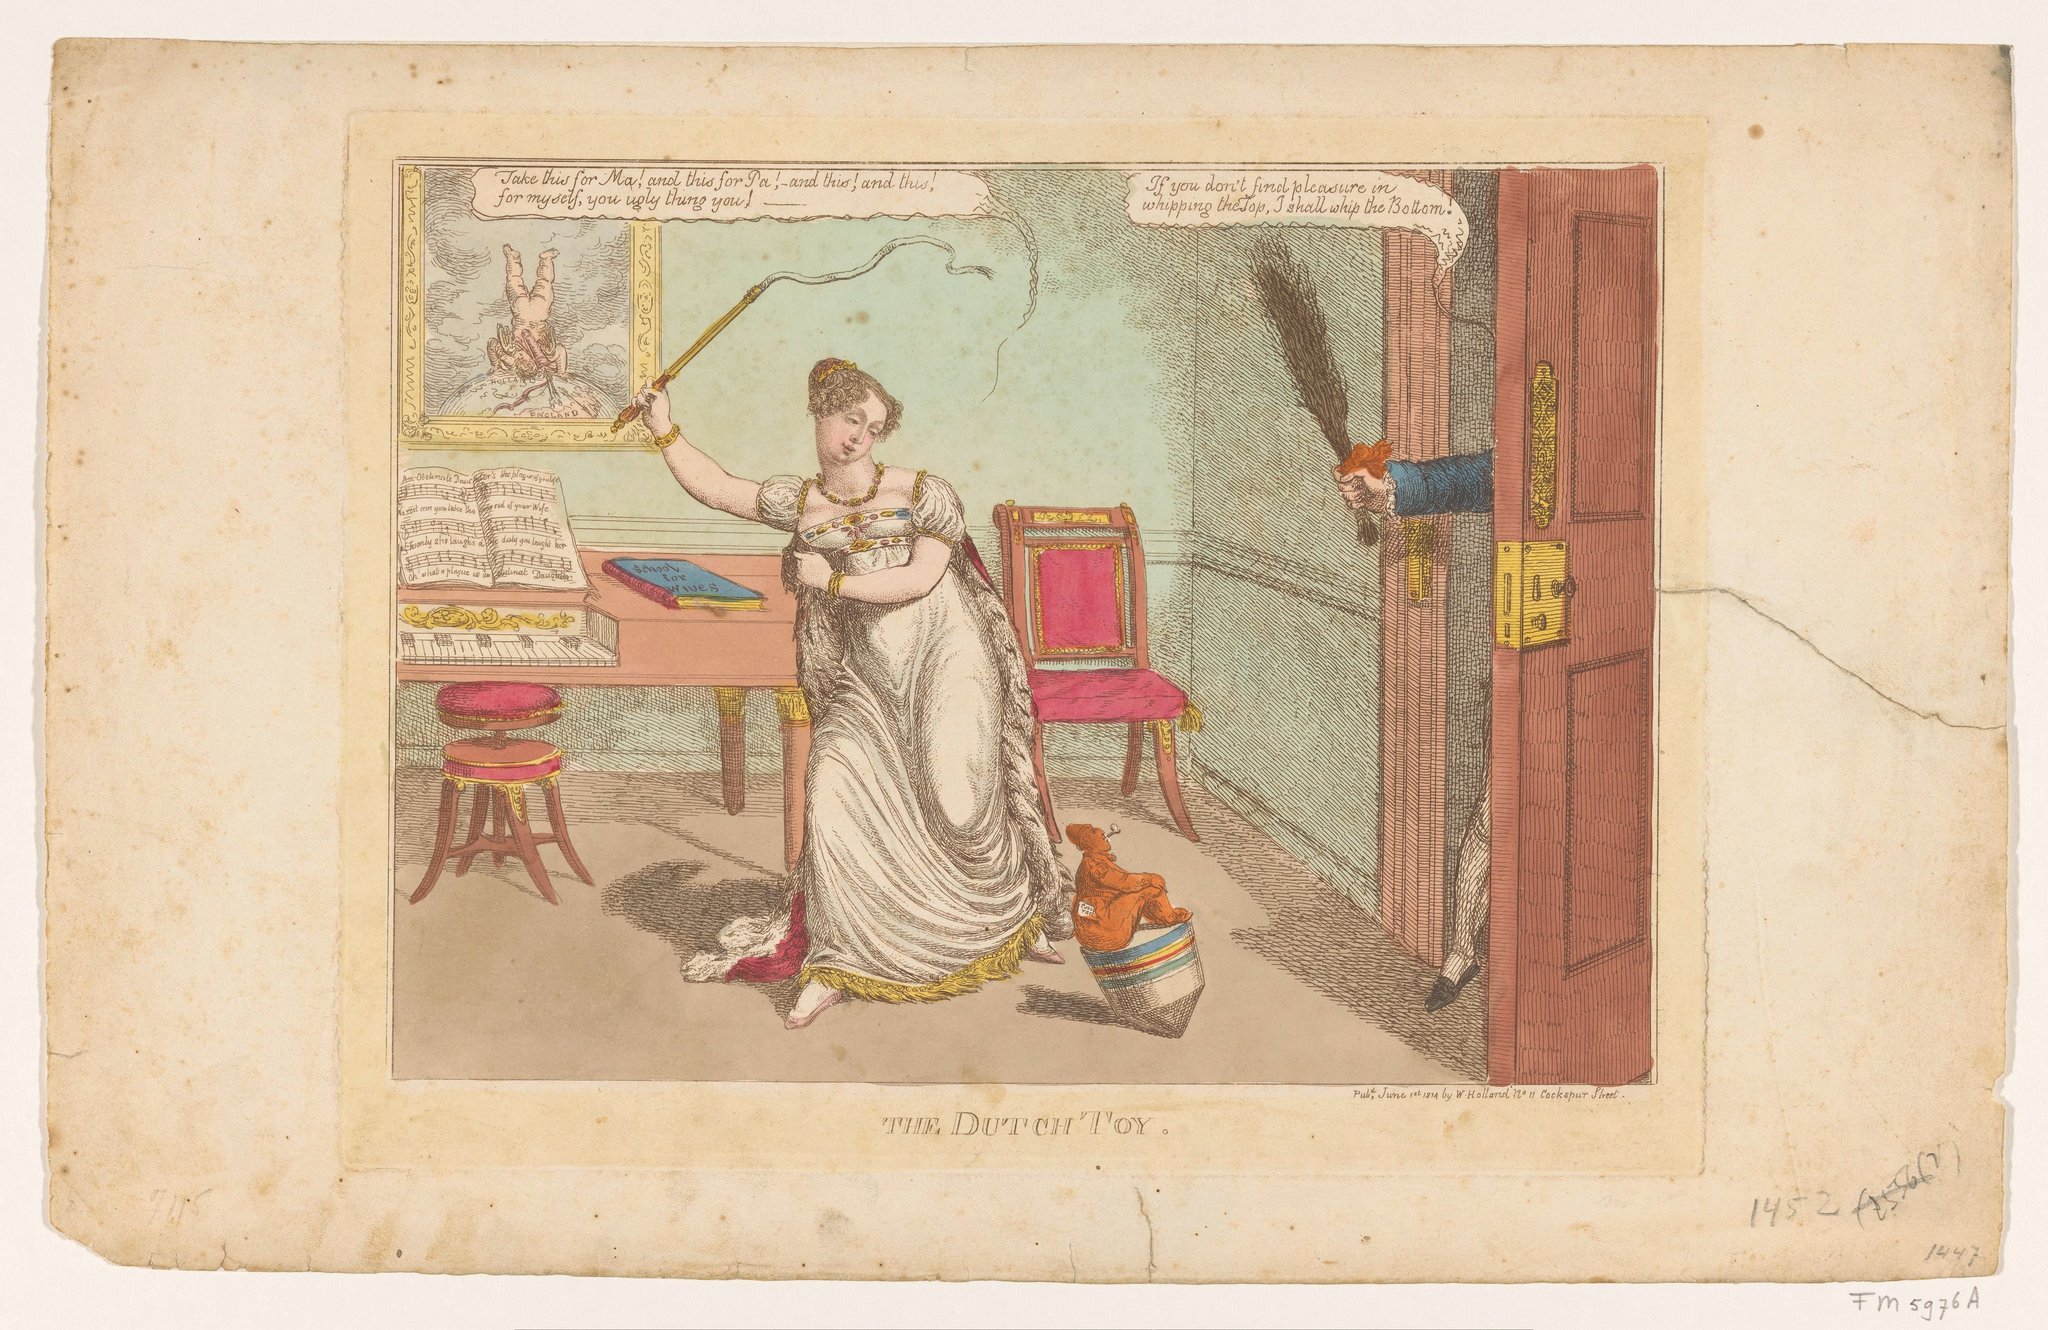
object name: cartoon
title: The Dutch Toy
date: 1814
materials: paper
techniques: etching, hand coloring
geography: london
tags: the hague, william ii of the netherlands, whipping a top, unsuccessful love affair; seduction, political caricatures and satires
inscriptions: date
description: Spotprent op Willem Frederik George Lodewijk, prins van Oranje-Nassau (later koning Willem II), voorgesteld als een kleine figuur zittend bovenop een tol door de Engelse prinses Charlotte met een zweep geslagen wordt. Een figuur komend door de deur rechts reikt de prinses een takkenbos aan om mee te slaan. Kamerinterieur met links een piano en daarboven een schilderij van Cupido die op zijn kop staat bovenop de wereldbol. Charlotte verbrak in mei 1814 haar verloving met de prins van Oranje. Zie pendant.